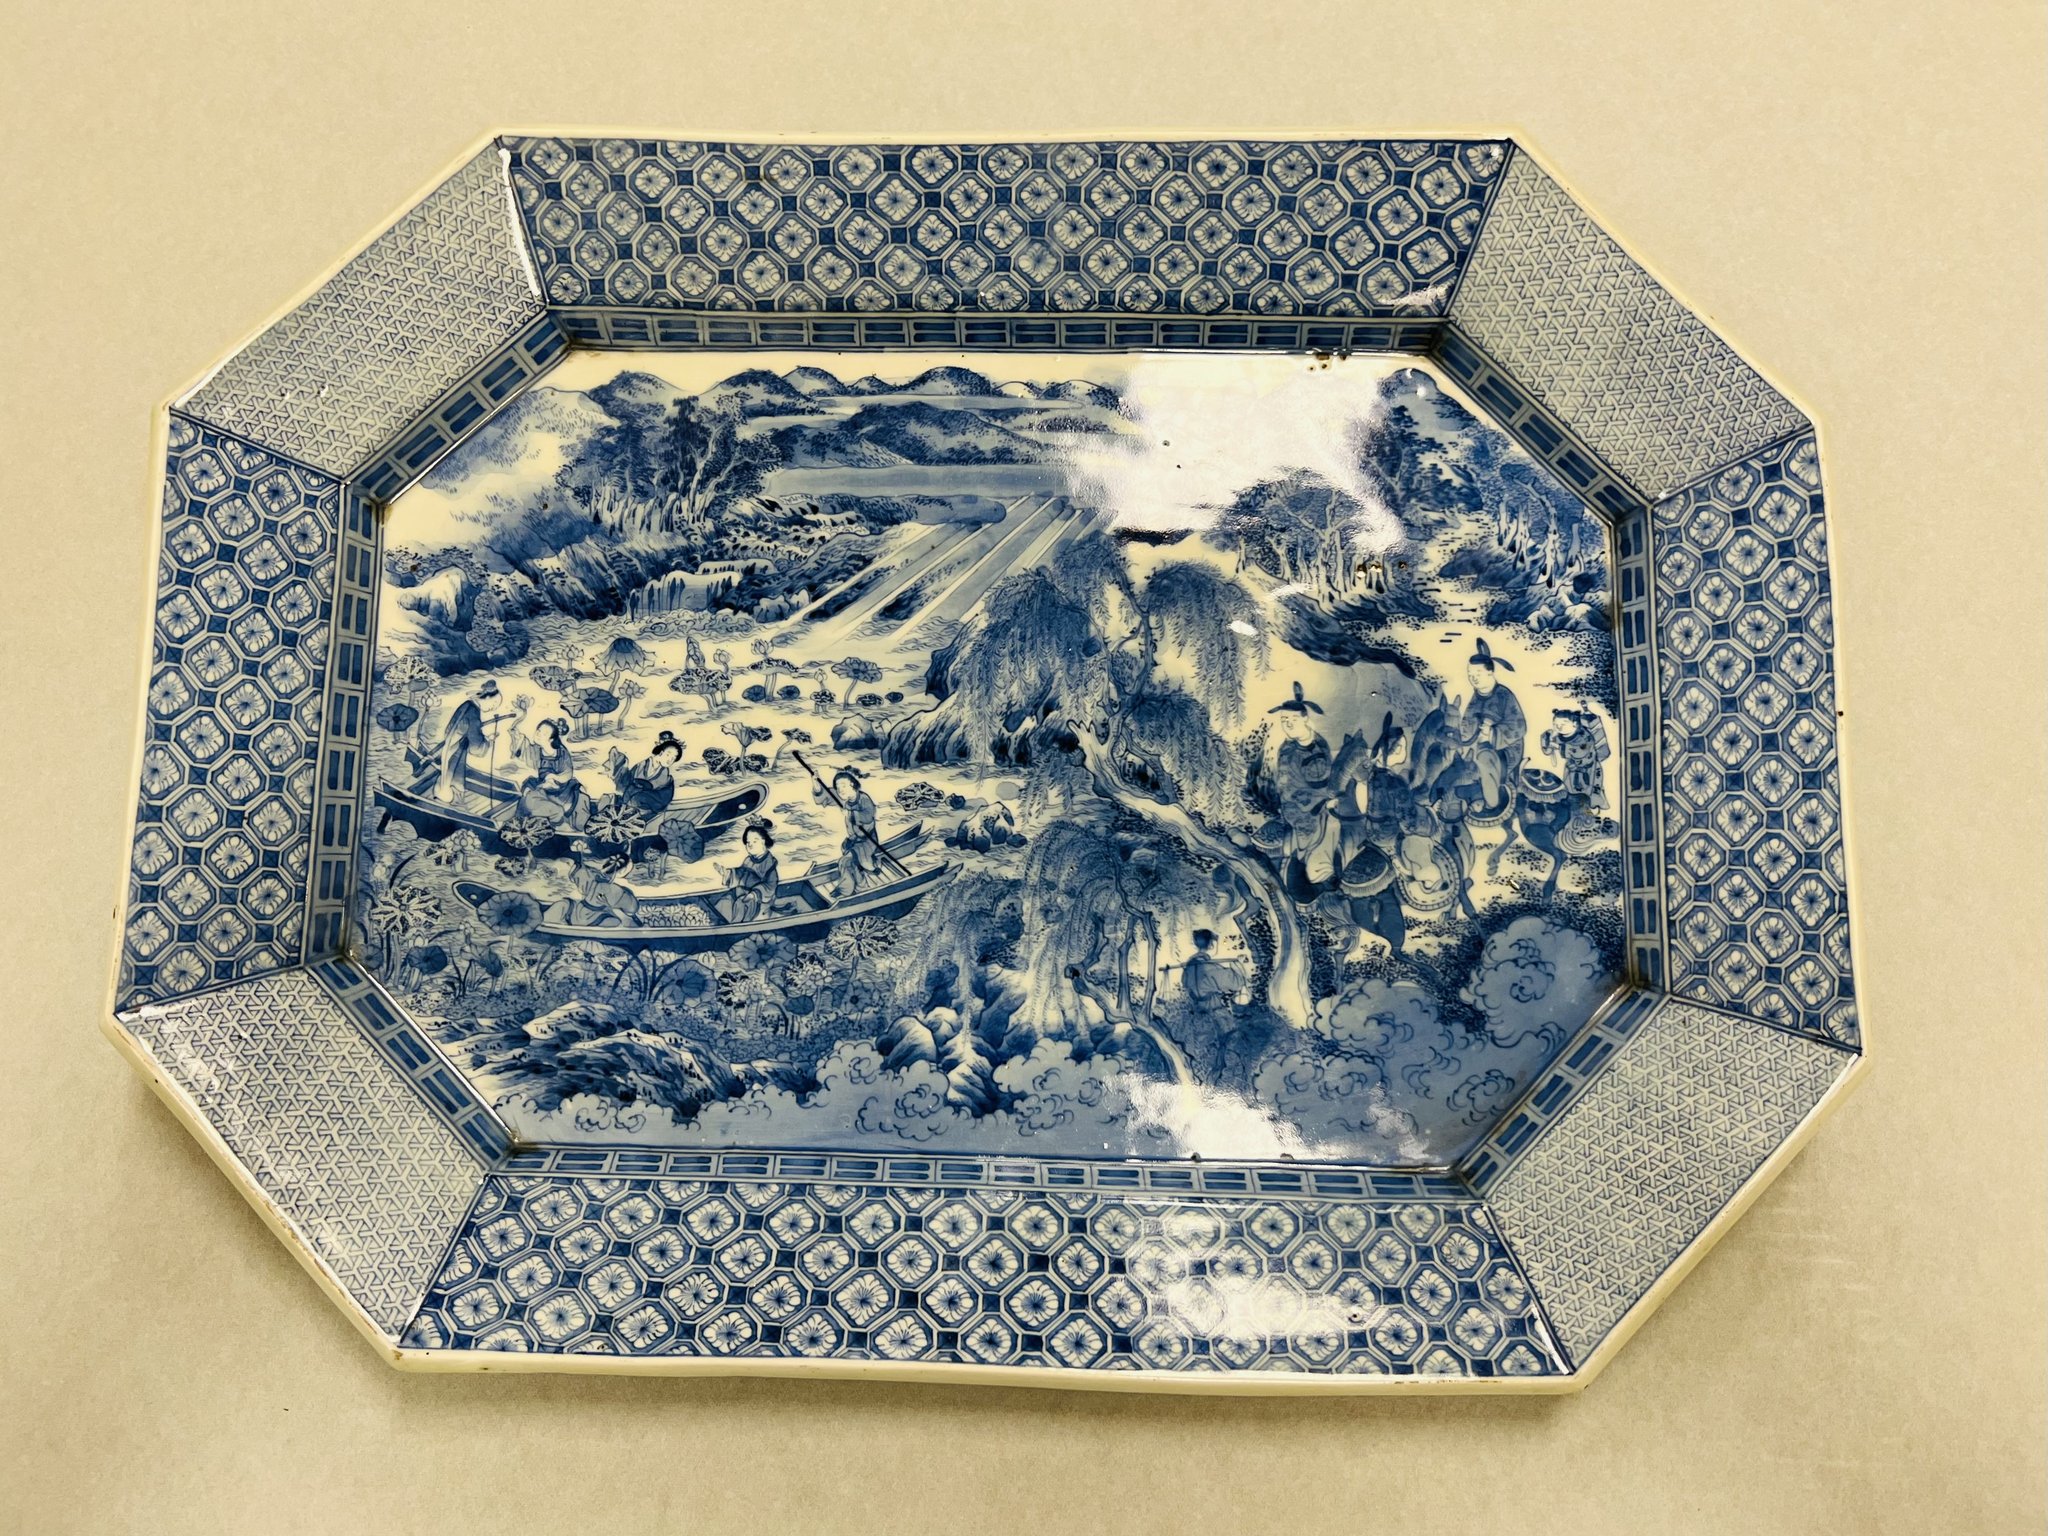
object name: large octagonal plate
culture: japanese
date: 1830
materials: glaze, porcelain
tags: men,waterfalls,boats